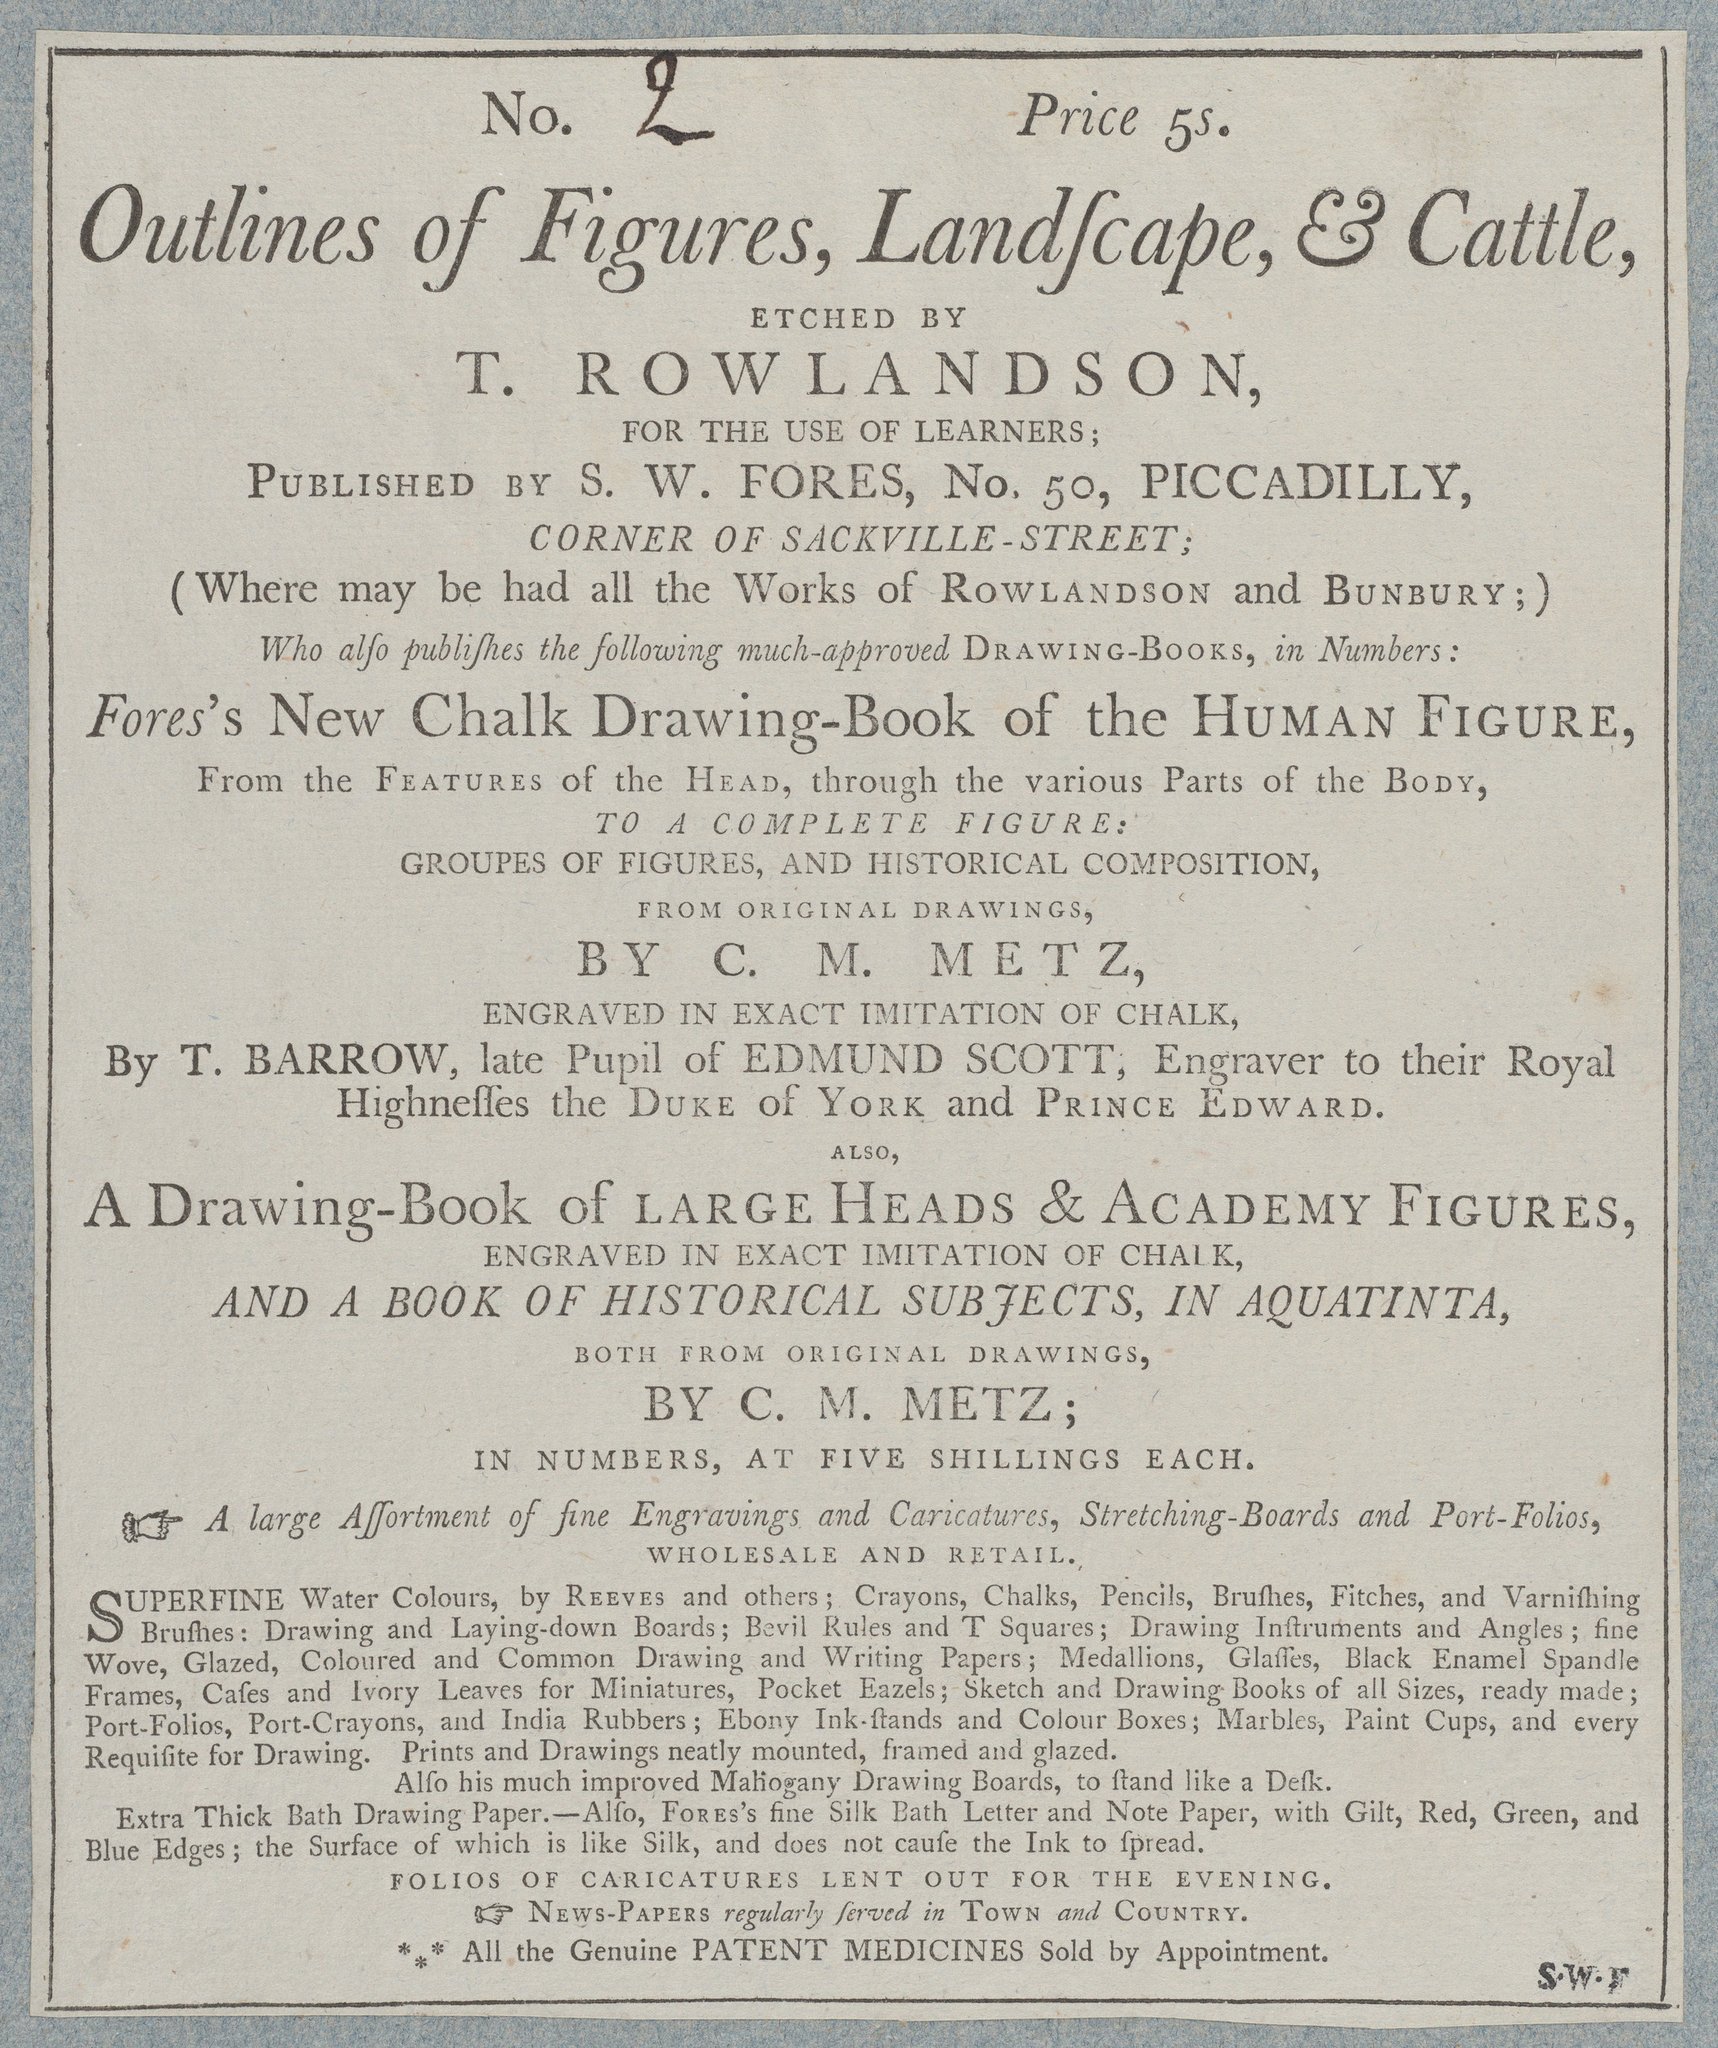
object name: print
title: Plate 1, Outlines of Figures, Landscapes and Cattle...for the Use of Learners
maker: thomas rowlandson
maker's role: artist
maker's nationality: british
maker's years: 1757-1827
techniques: etching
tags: men,women,deer,horses,carriages